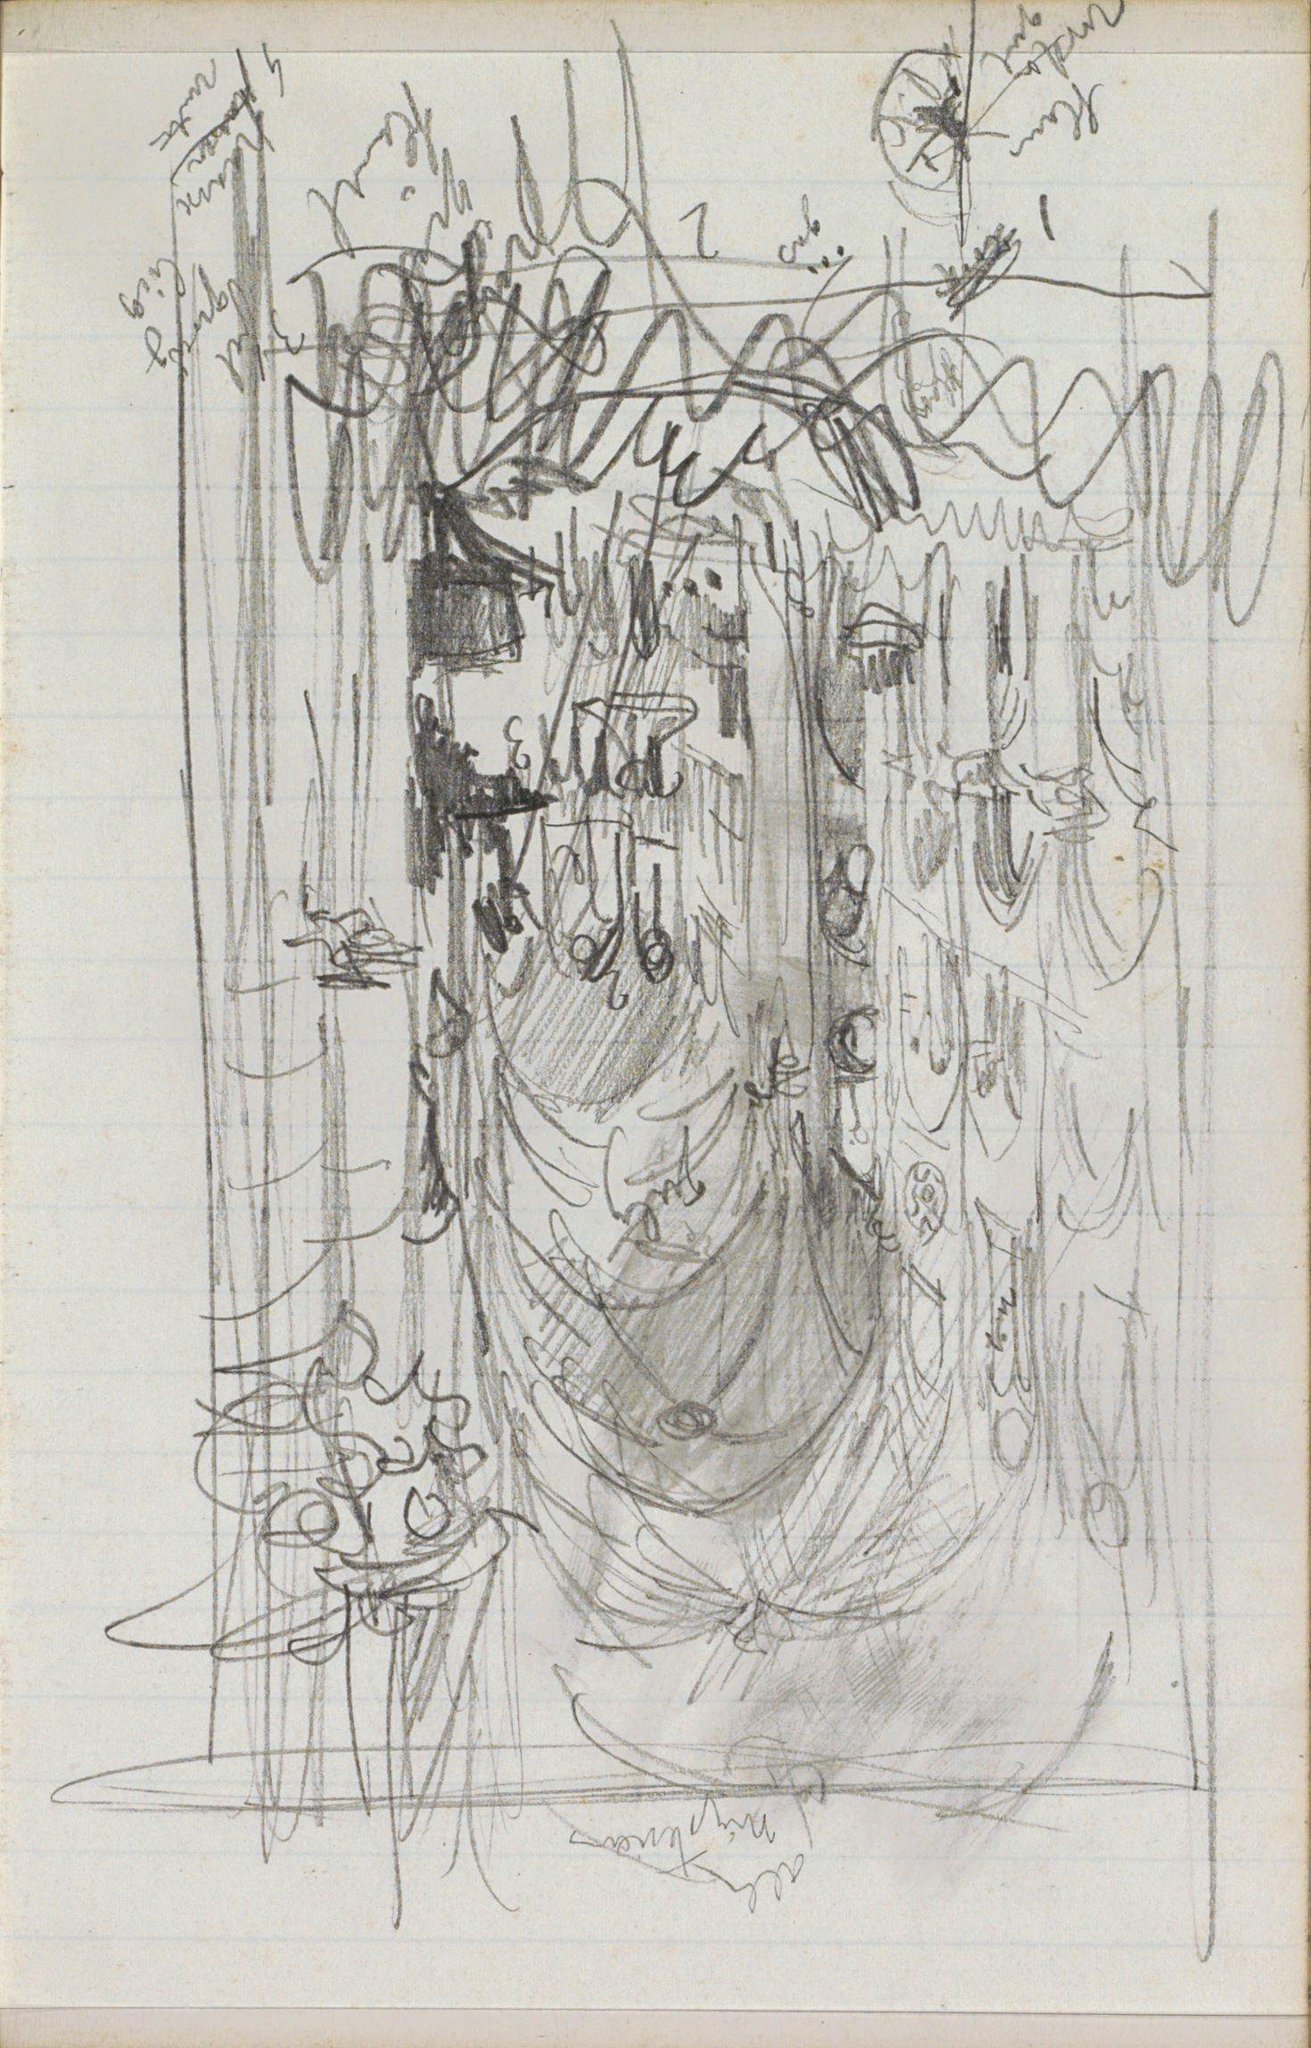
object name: sketchbook leaf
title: Interieur van de Notre-Dame, Parijs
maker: marius bauer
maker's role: draughtsman, print maker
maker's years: 1867-1932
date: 1877-1932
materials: pencil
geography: paris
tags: interior of church, paris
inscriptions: kleurnotitie, handgeschreven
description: Pagina 46 uit een schetsboek met 68 bladen.